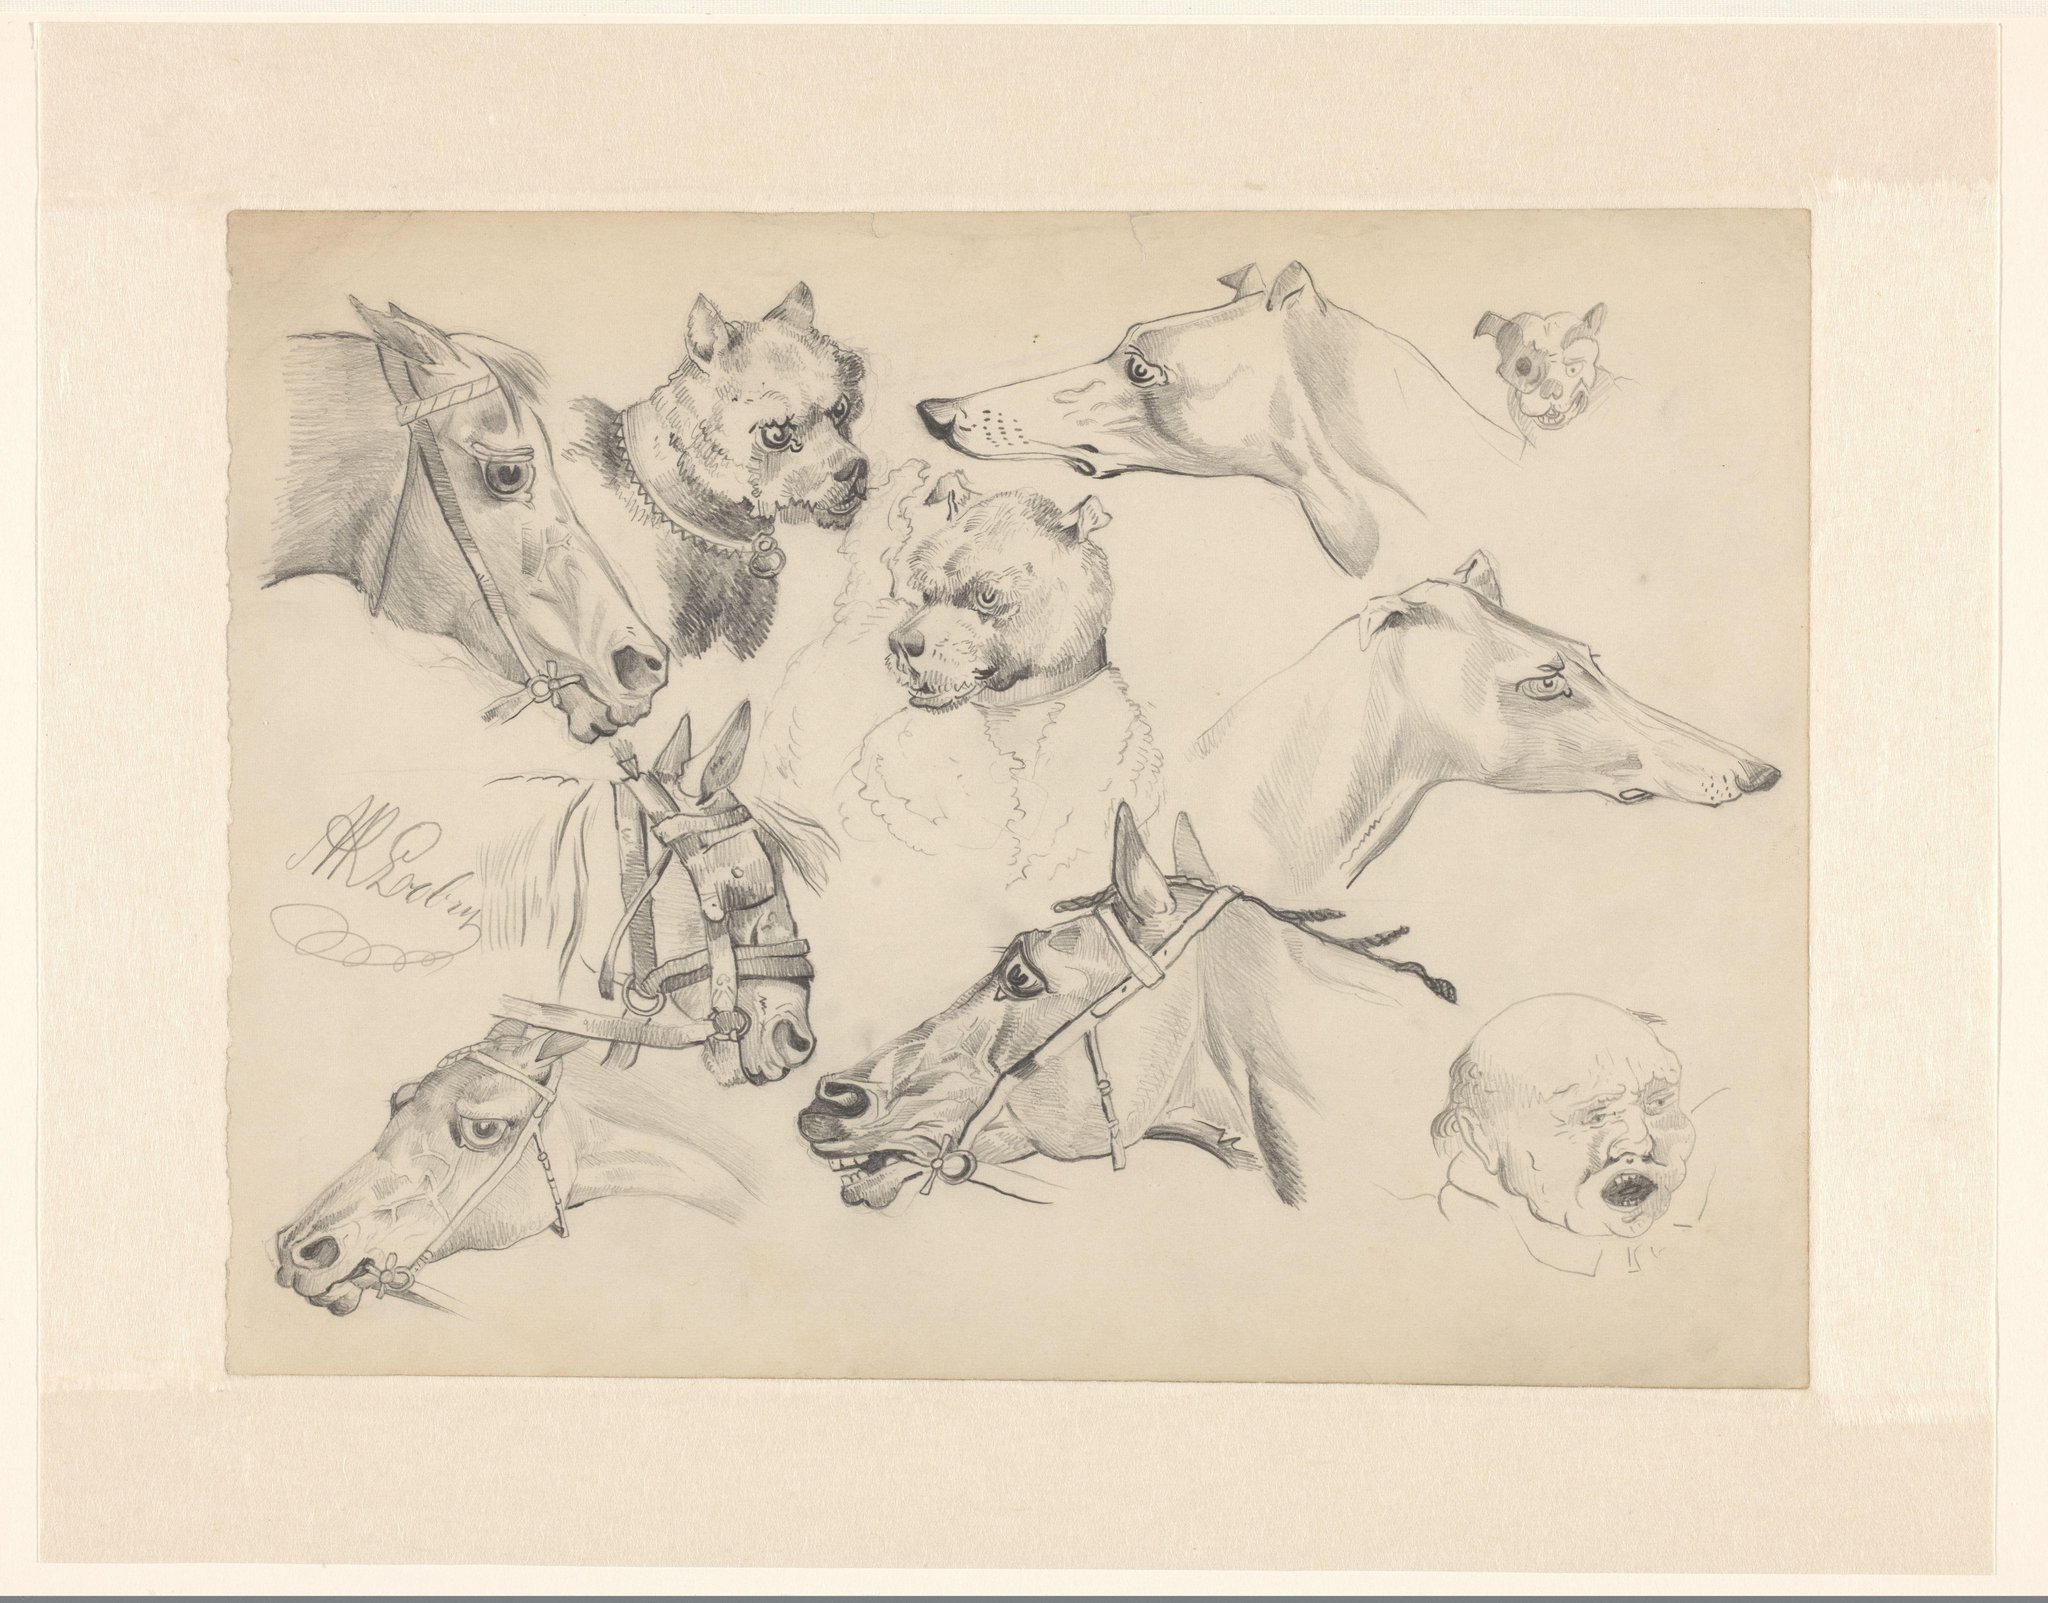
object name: drawing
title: Studieblad met paarden, honden en hoofd van een man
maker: adrien rené lobry-visbach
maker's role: draughtsman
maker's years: 1840-1888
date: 1850-1888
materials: paper, pencil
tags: head (human), horse, dog